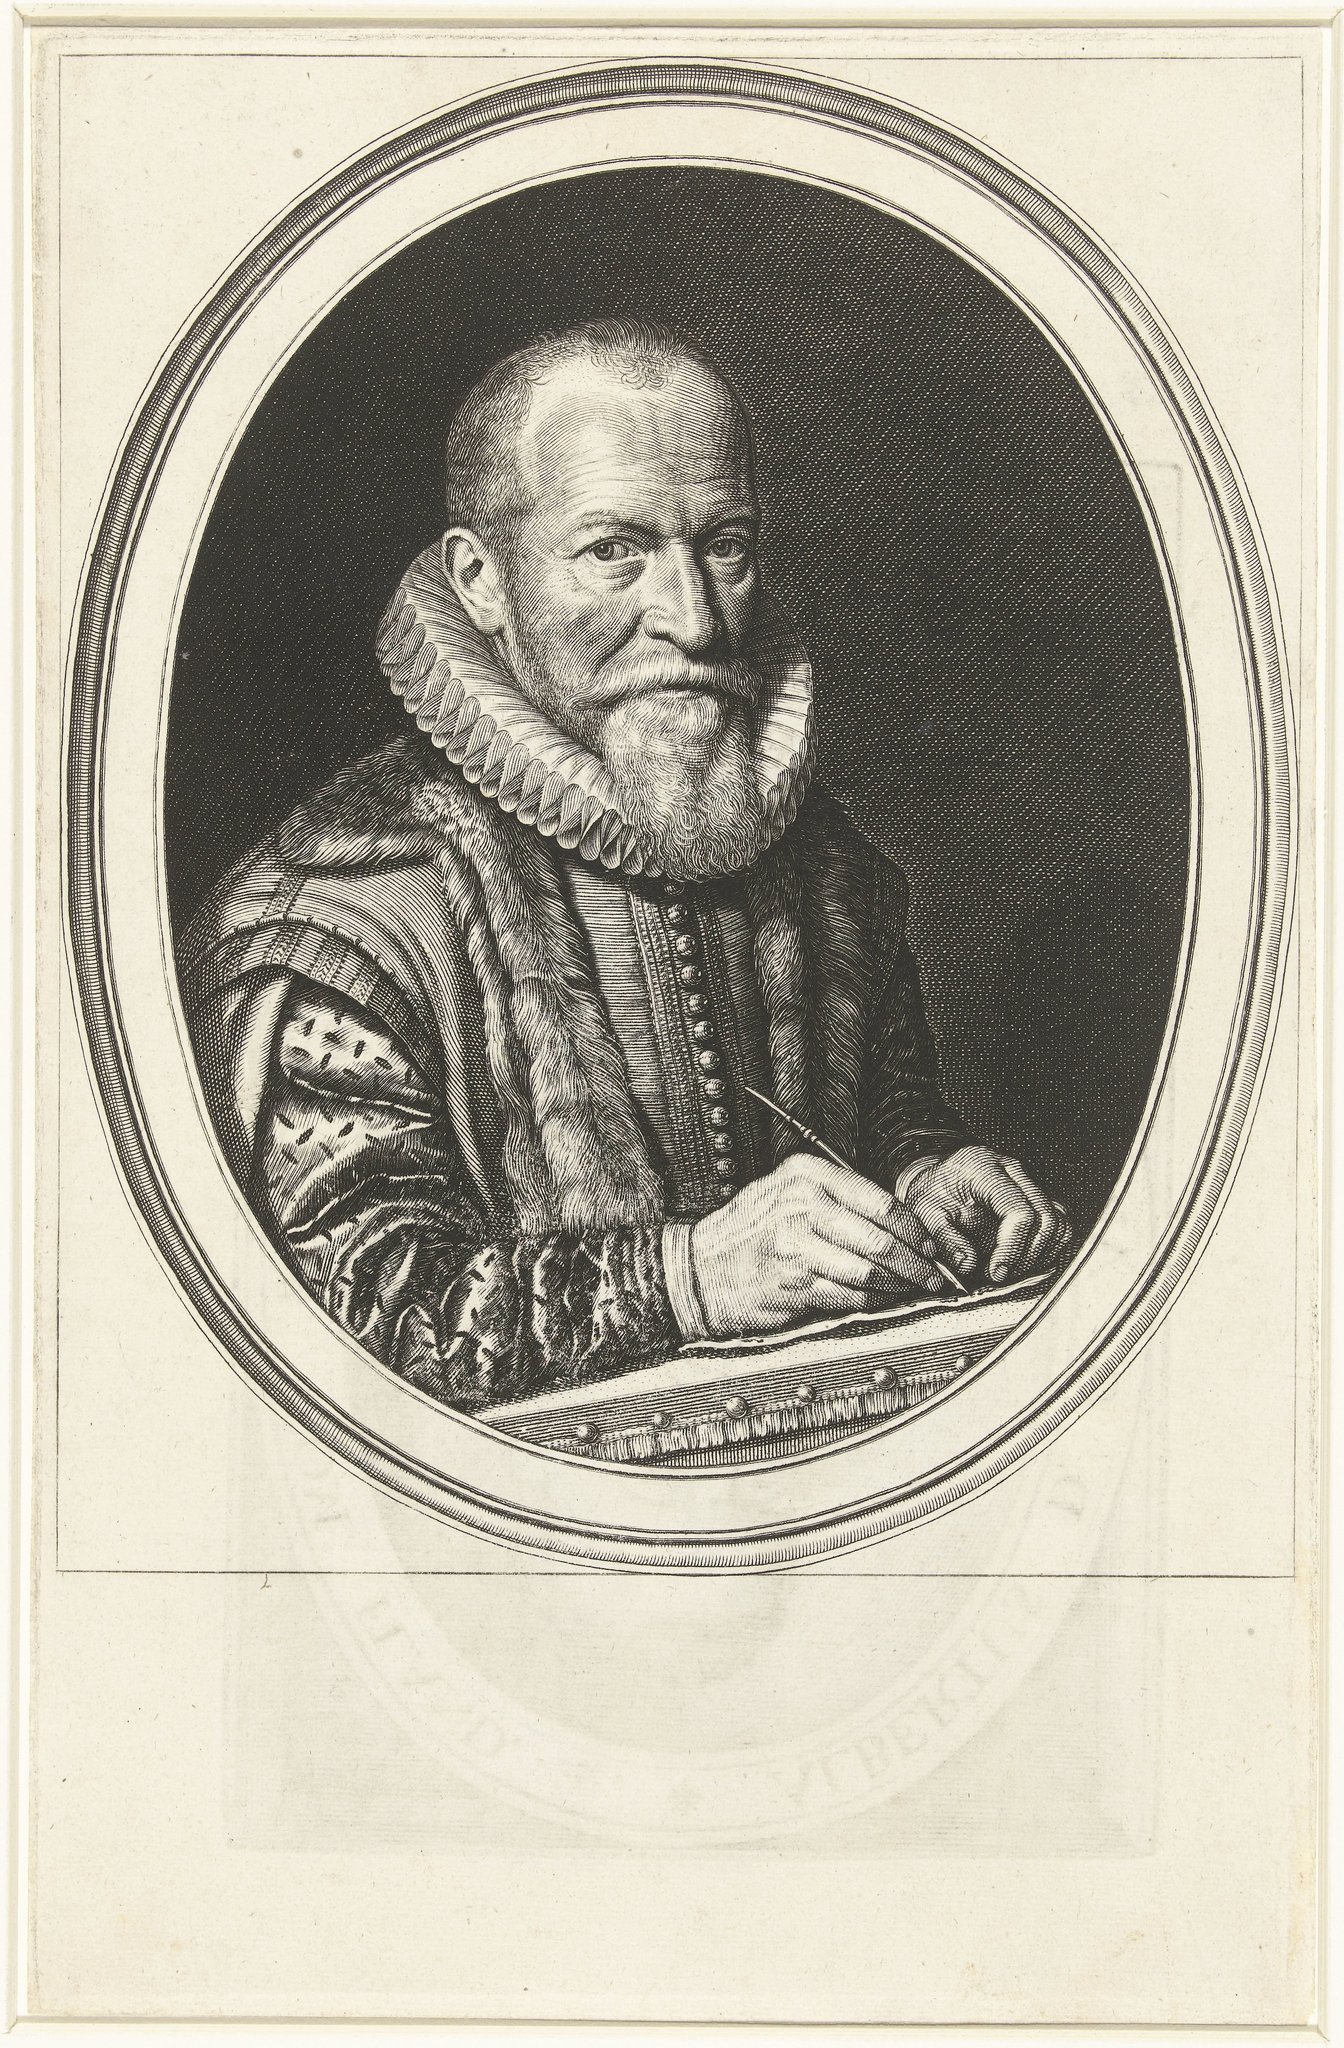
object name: print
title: Portret van kalligraaf Felix van Sambix op 66-jarige leeftijd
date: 1619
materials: paper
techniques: engraving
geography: delft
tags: antwerp, delft, publisher, felix van sambix, calligraphy (+ portrait of scholar, scientist)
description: Portret van kalligraaf Felix van Sambix op 66-jarige leeftijd, ten halven lijve zittend aan schrijftafel met pen en papier in ovale omlijsting.